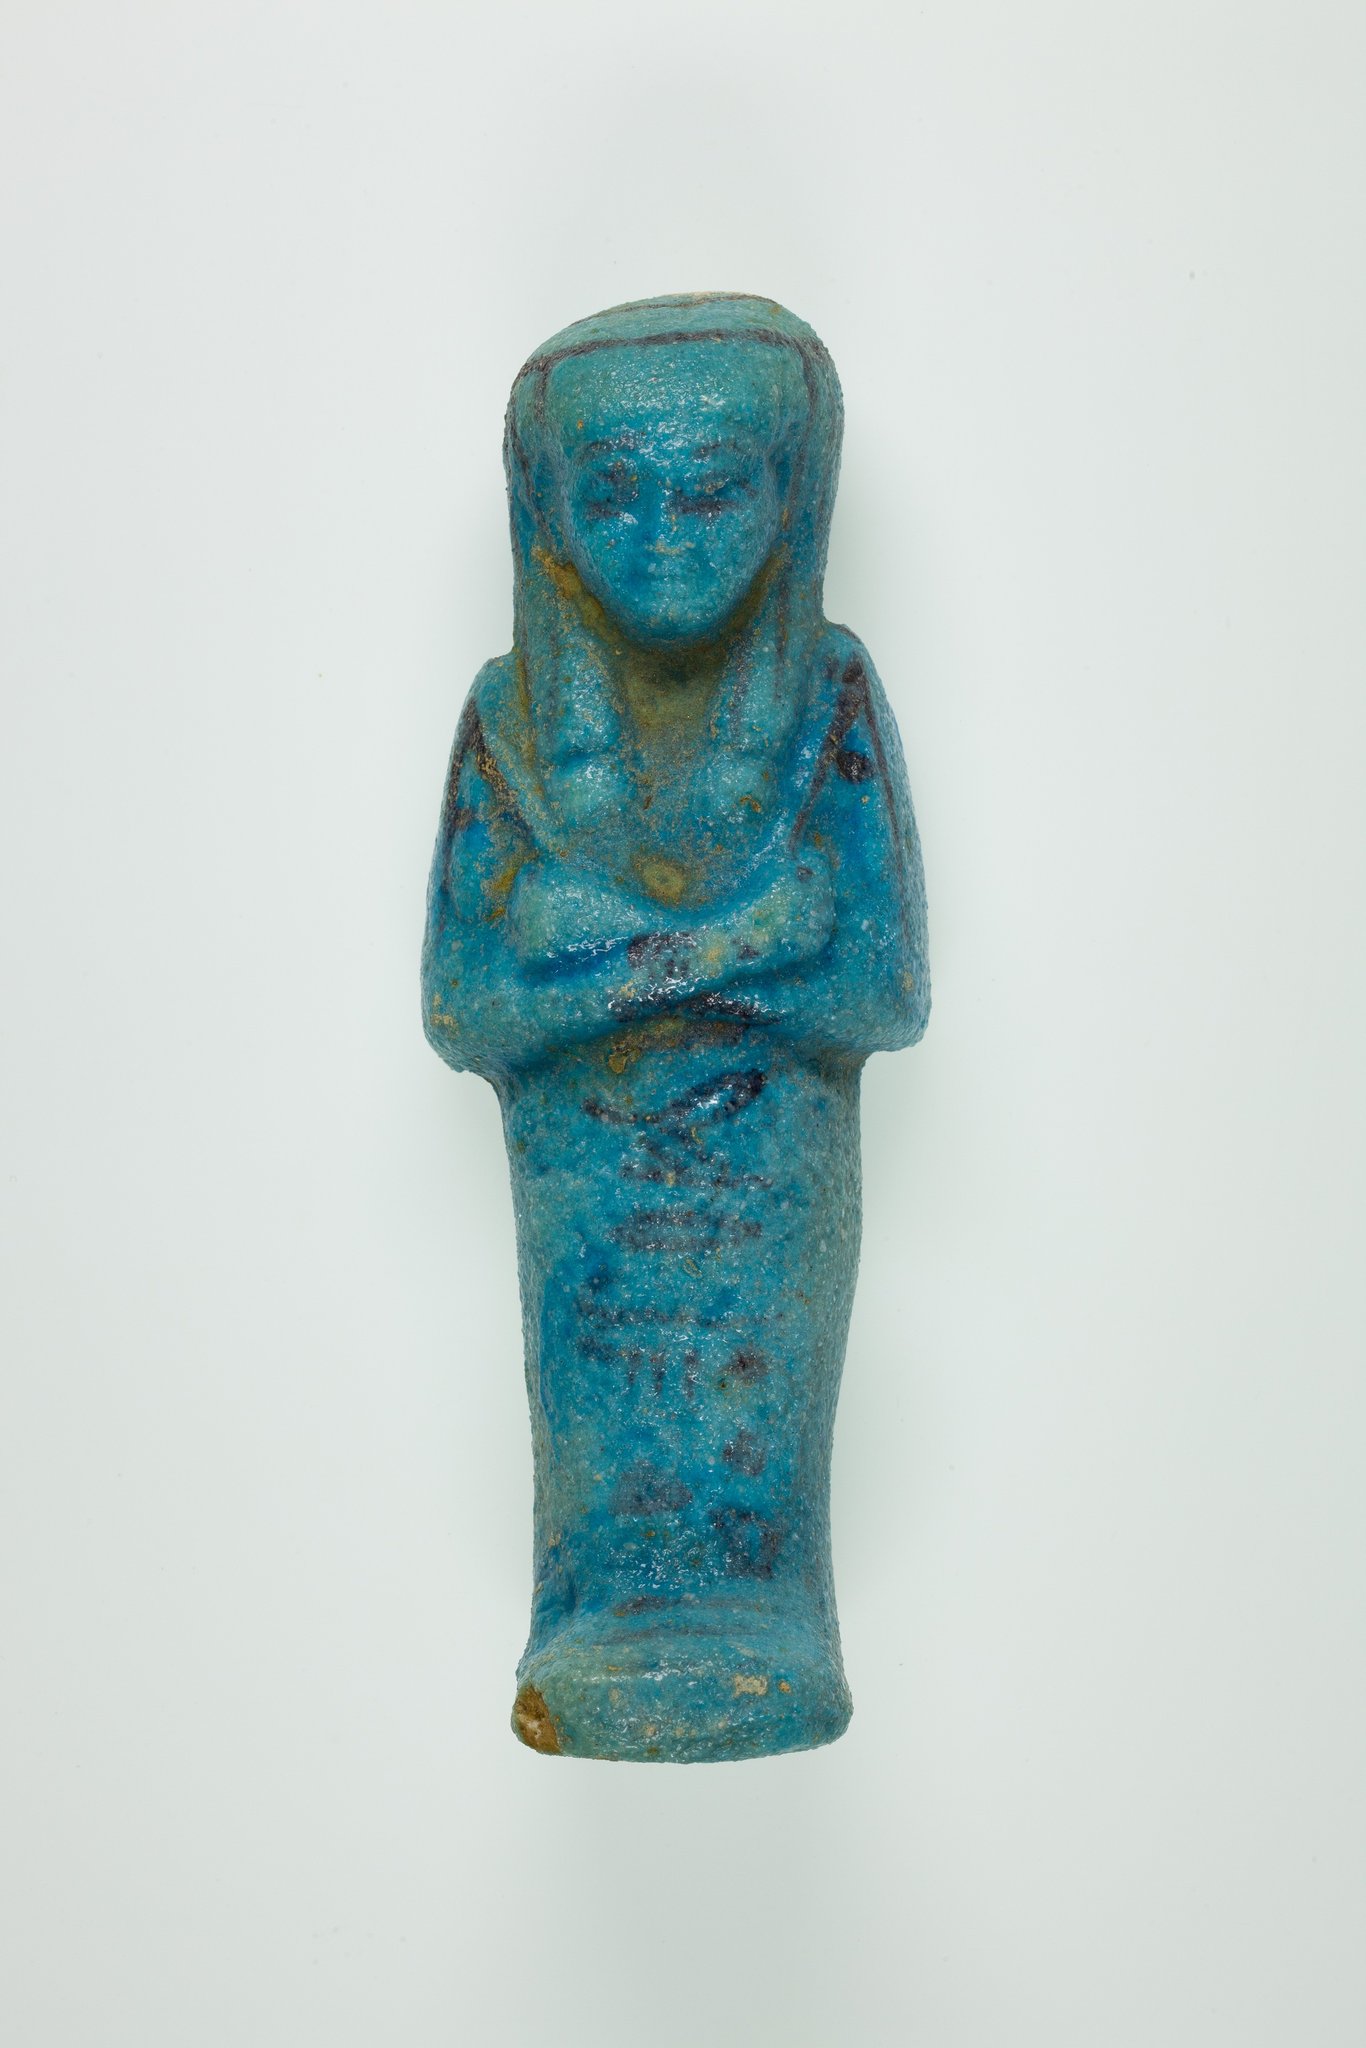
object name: worker shabti, henettawy c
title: Worker Shabti of Henettawy (C), Daughter of Isetemkheb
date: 990-970 BCE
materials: faience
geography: egypt